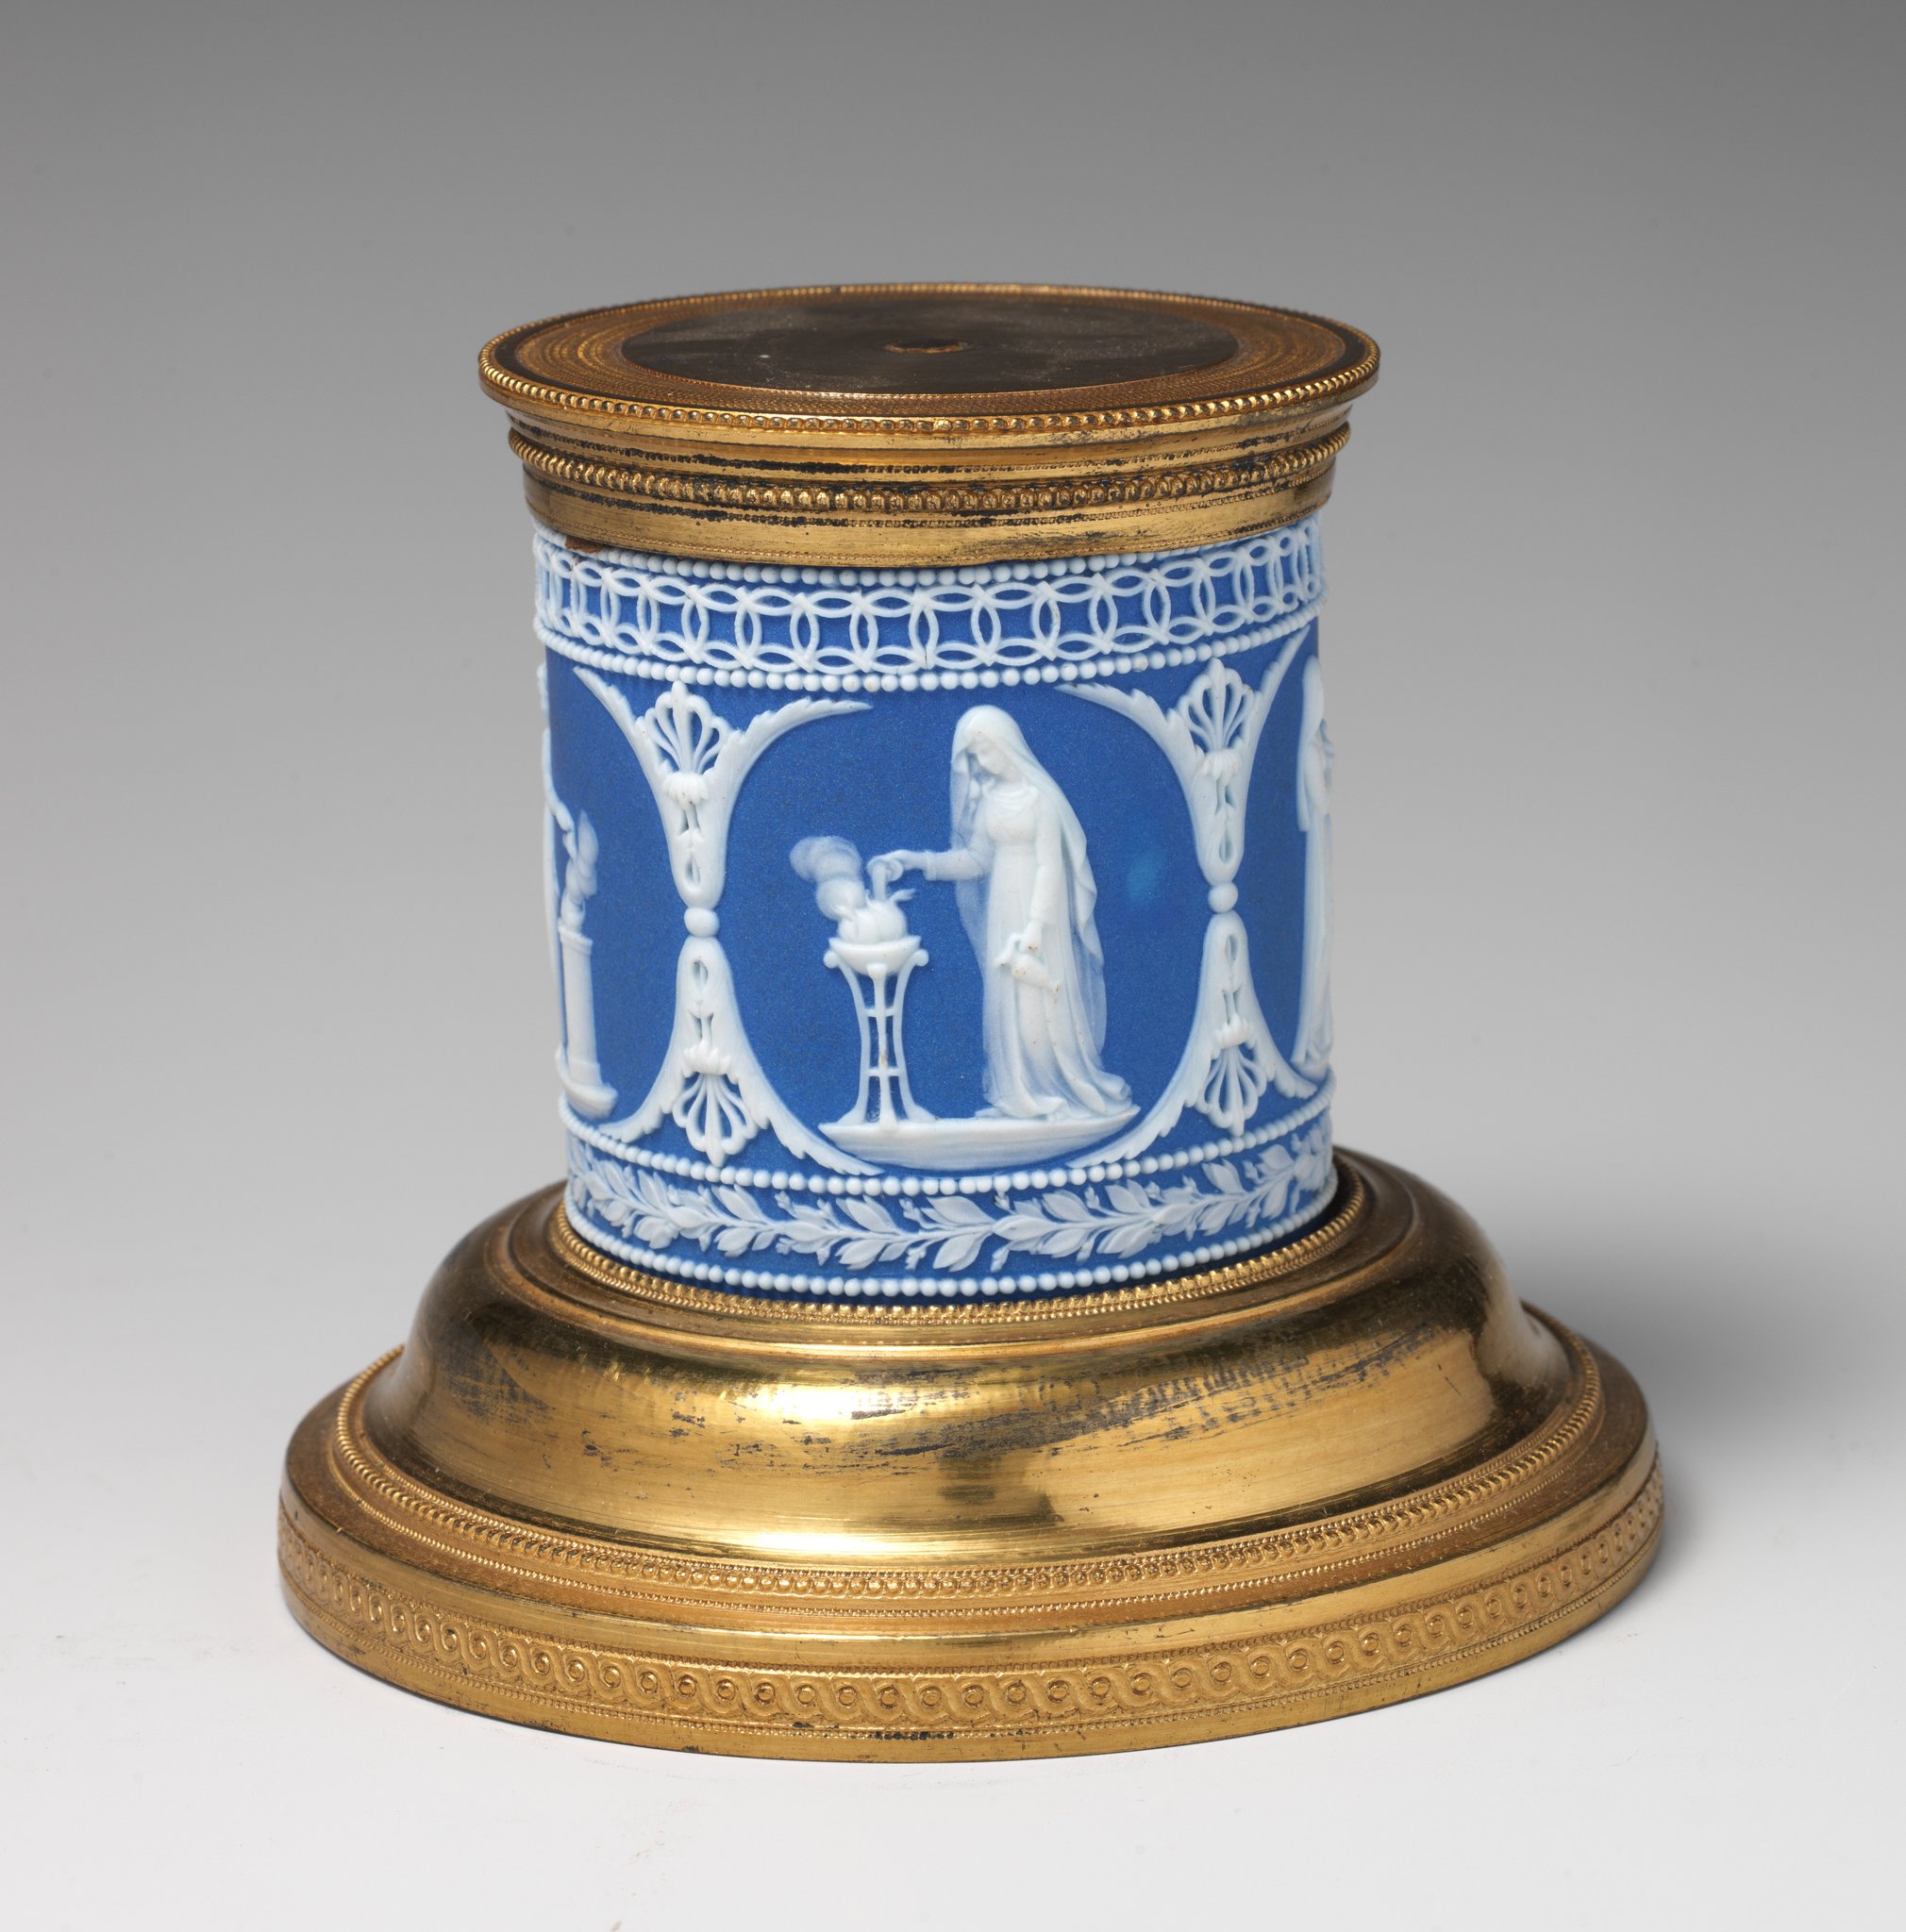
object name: base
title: Pair of bases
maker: william adams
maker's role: maker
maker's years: 1745-1805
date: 1787-1805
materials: gilt bronze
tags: women